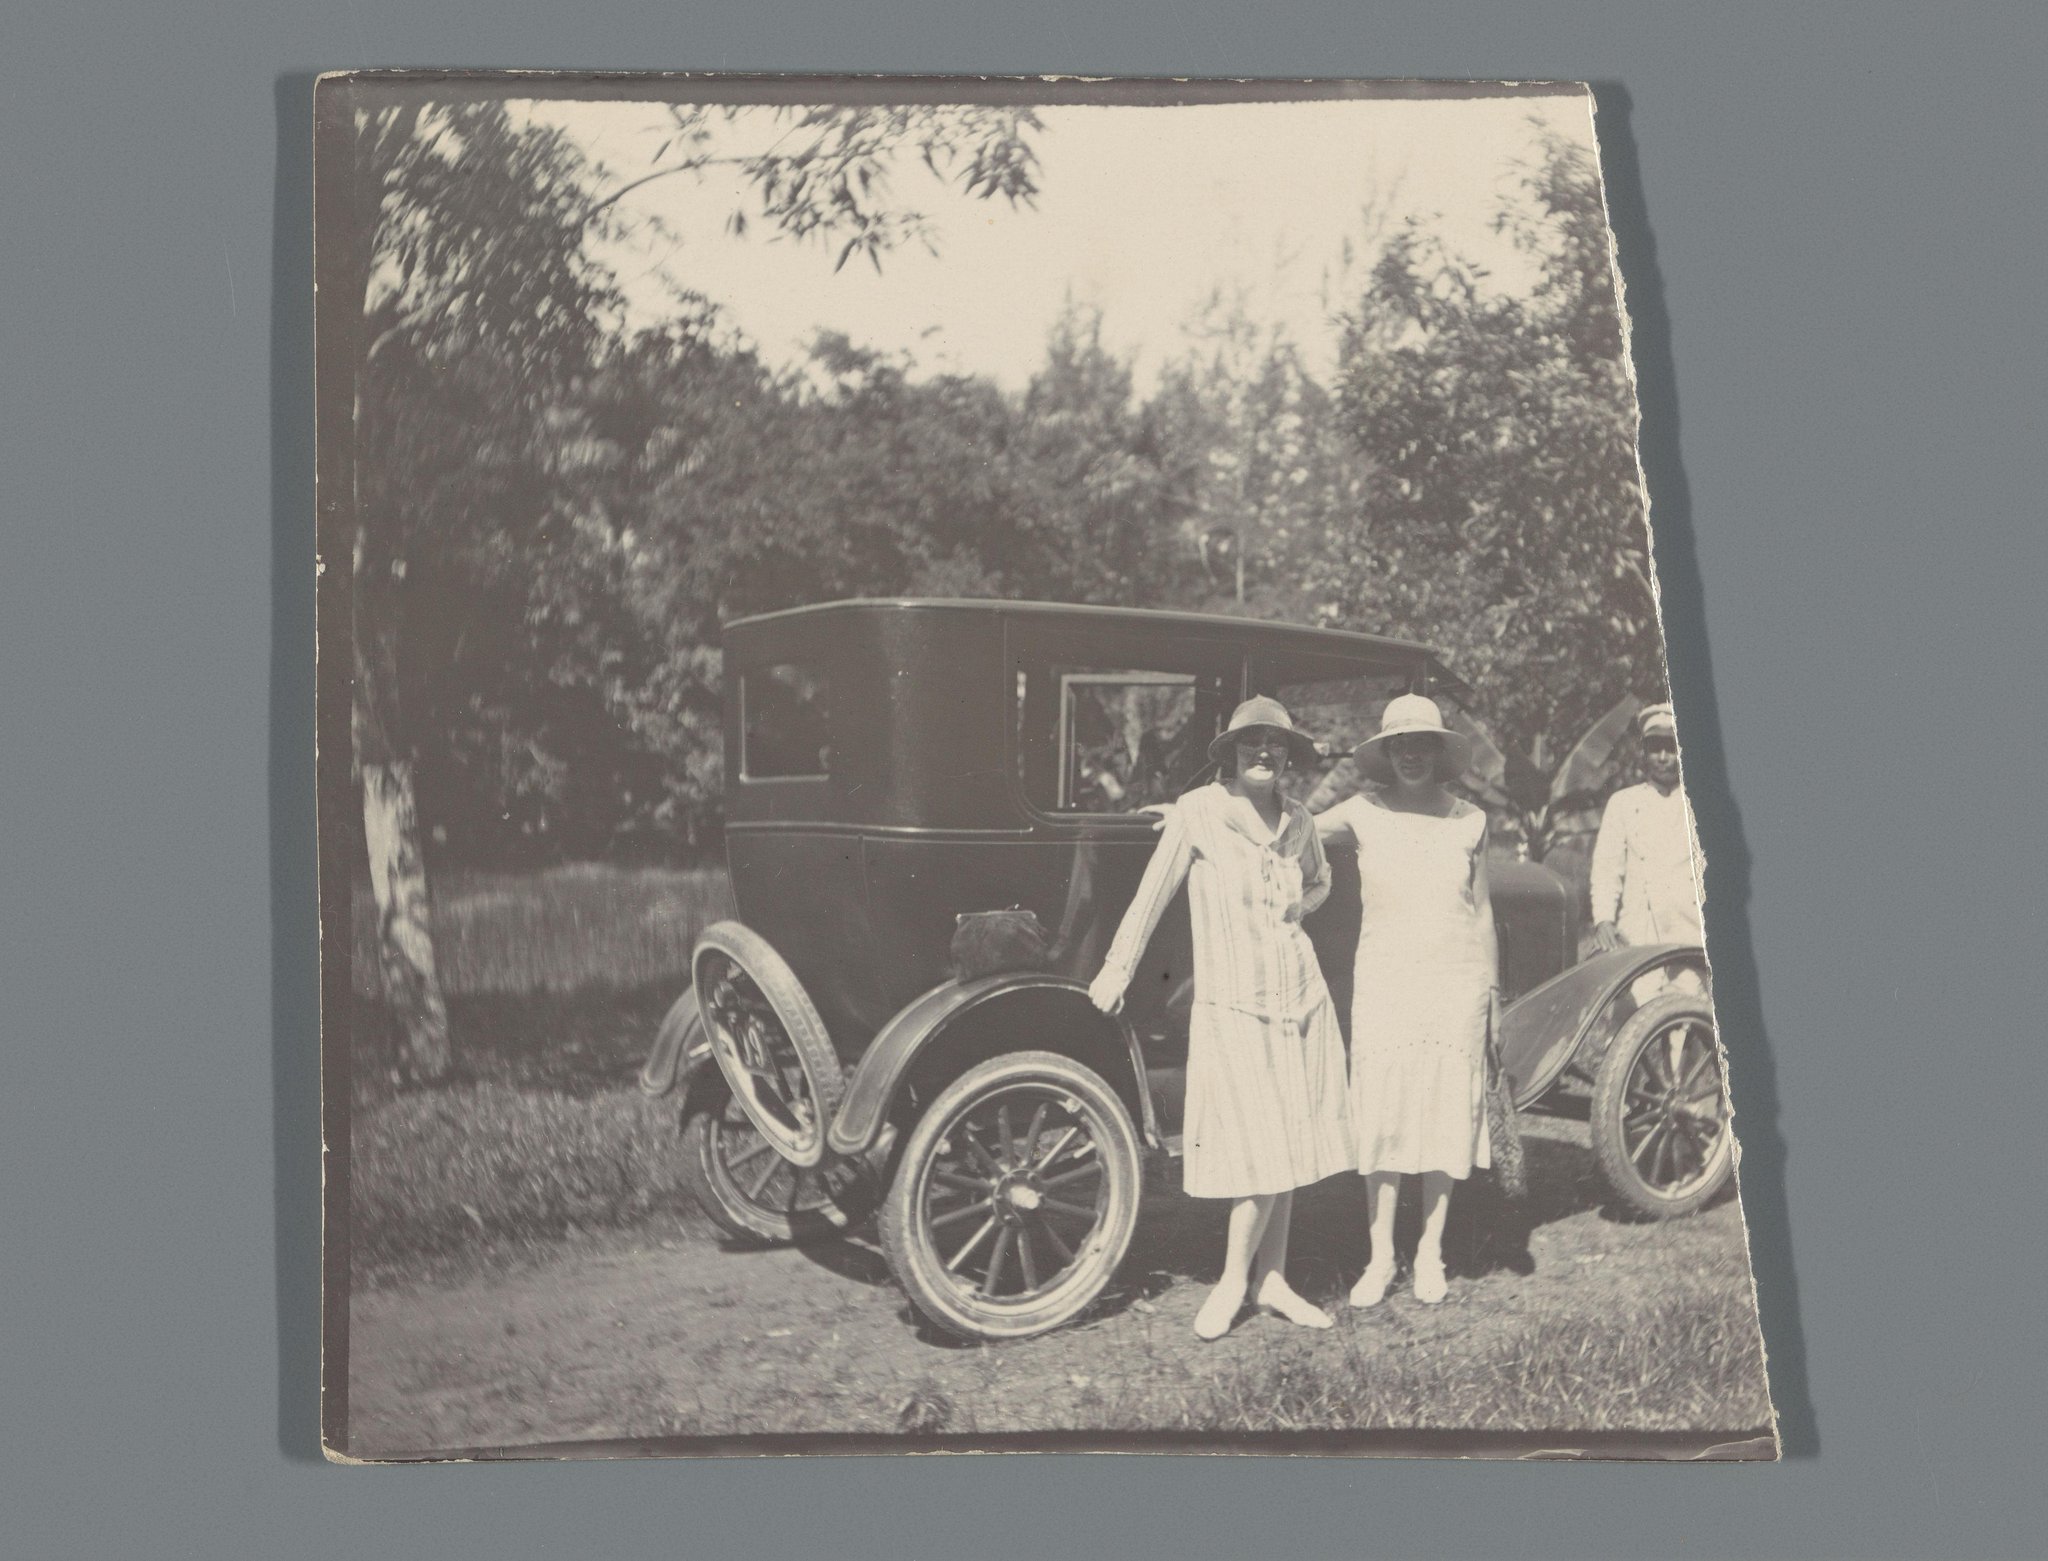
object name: photograph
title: Twee vrouwen voor een auto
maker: Anonymous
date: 1908-1926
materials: photographic support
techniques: photography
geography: suriname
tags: jetten, familie, moengo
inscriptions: inscription: ‘10 aug, 26: terug uit ziekenhuis / 25 aug 1926 trouwdatum’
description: Twee vrouwen (waarvan één waarschijnlijk Edith Jetten) staande voor een auto, rechts de chauffeur. Deel van de foto afgescheurd. Onderdeel van het ensemble met foto's van de familie van ingenieur Jetten in de mijnbouwstad Moengo in Suriname.